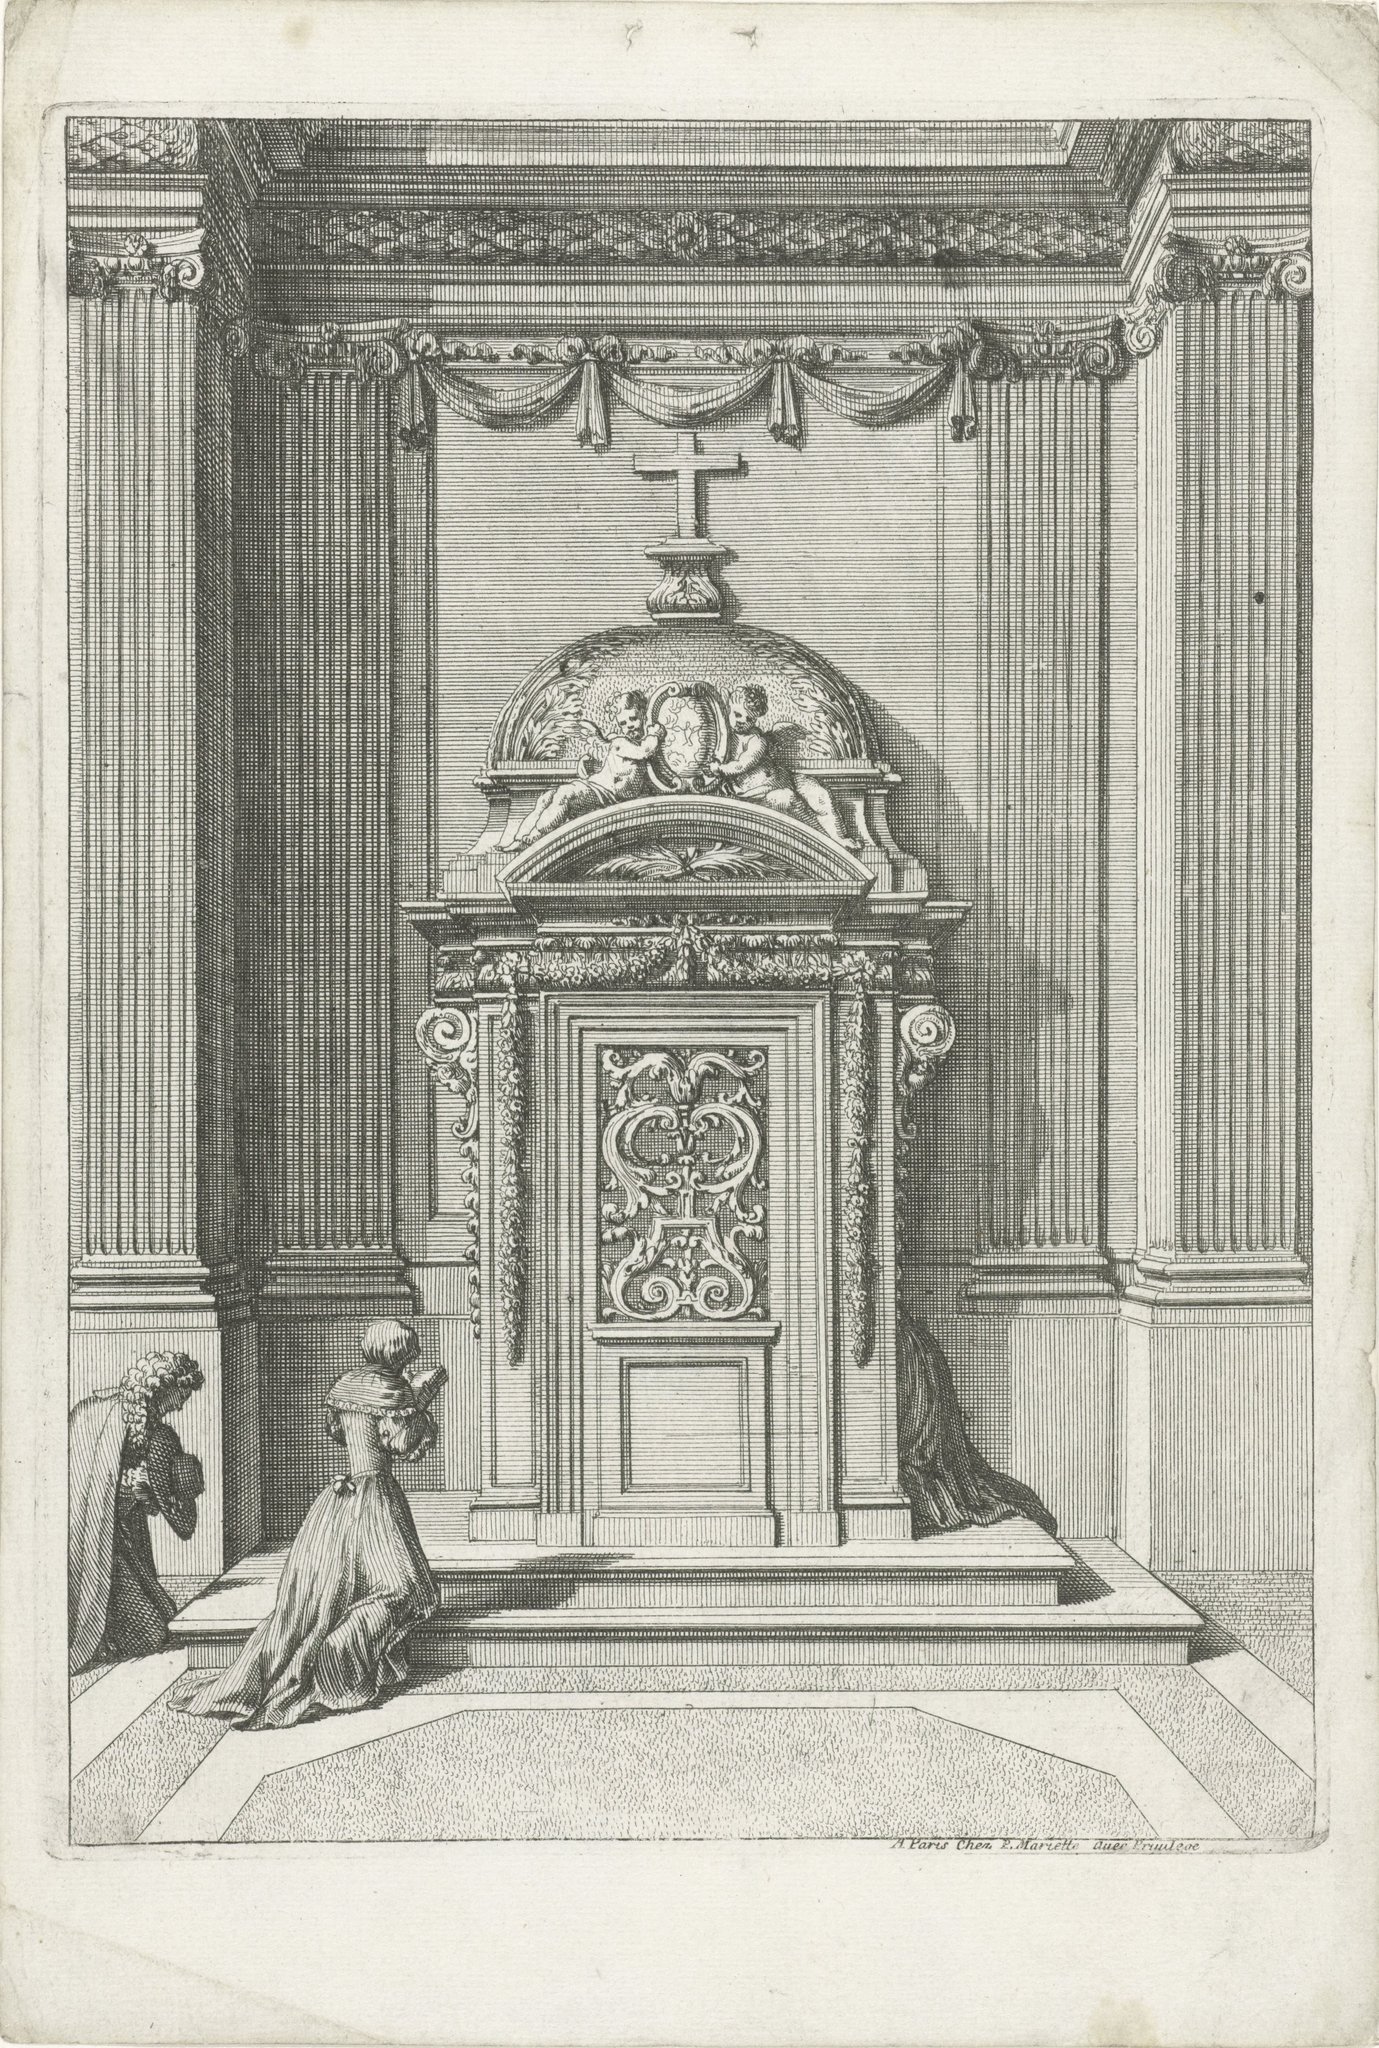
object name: print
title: Biechtstoel in nis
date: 1658-1670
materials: paper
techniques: etching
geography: france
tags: confessional ~ part of the confession